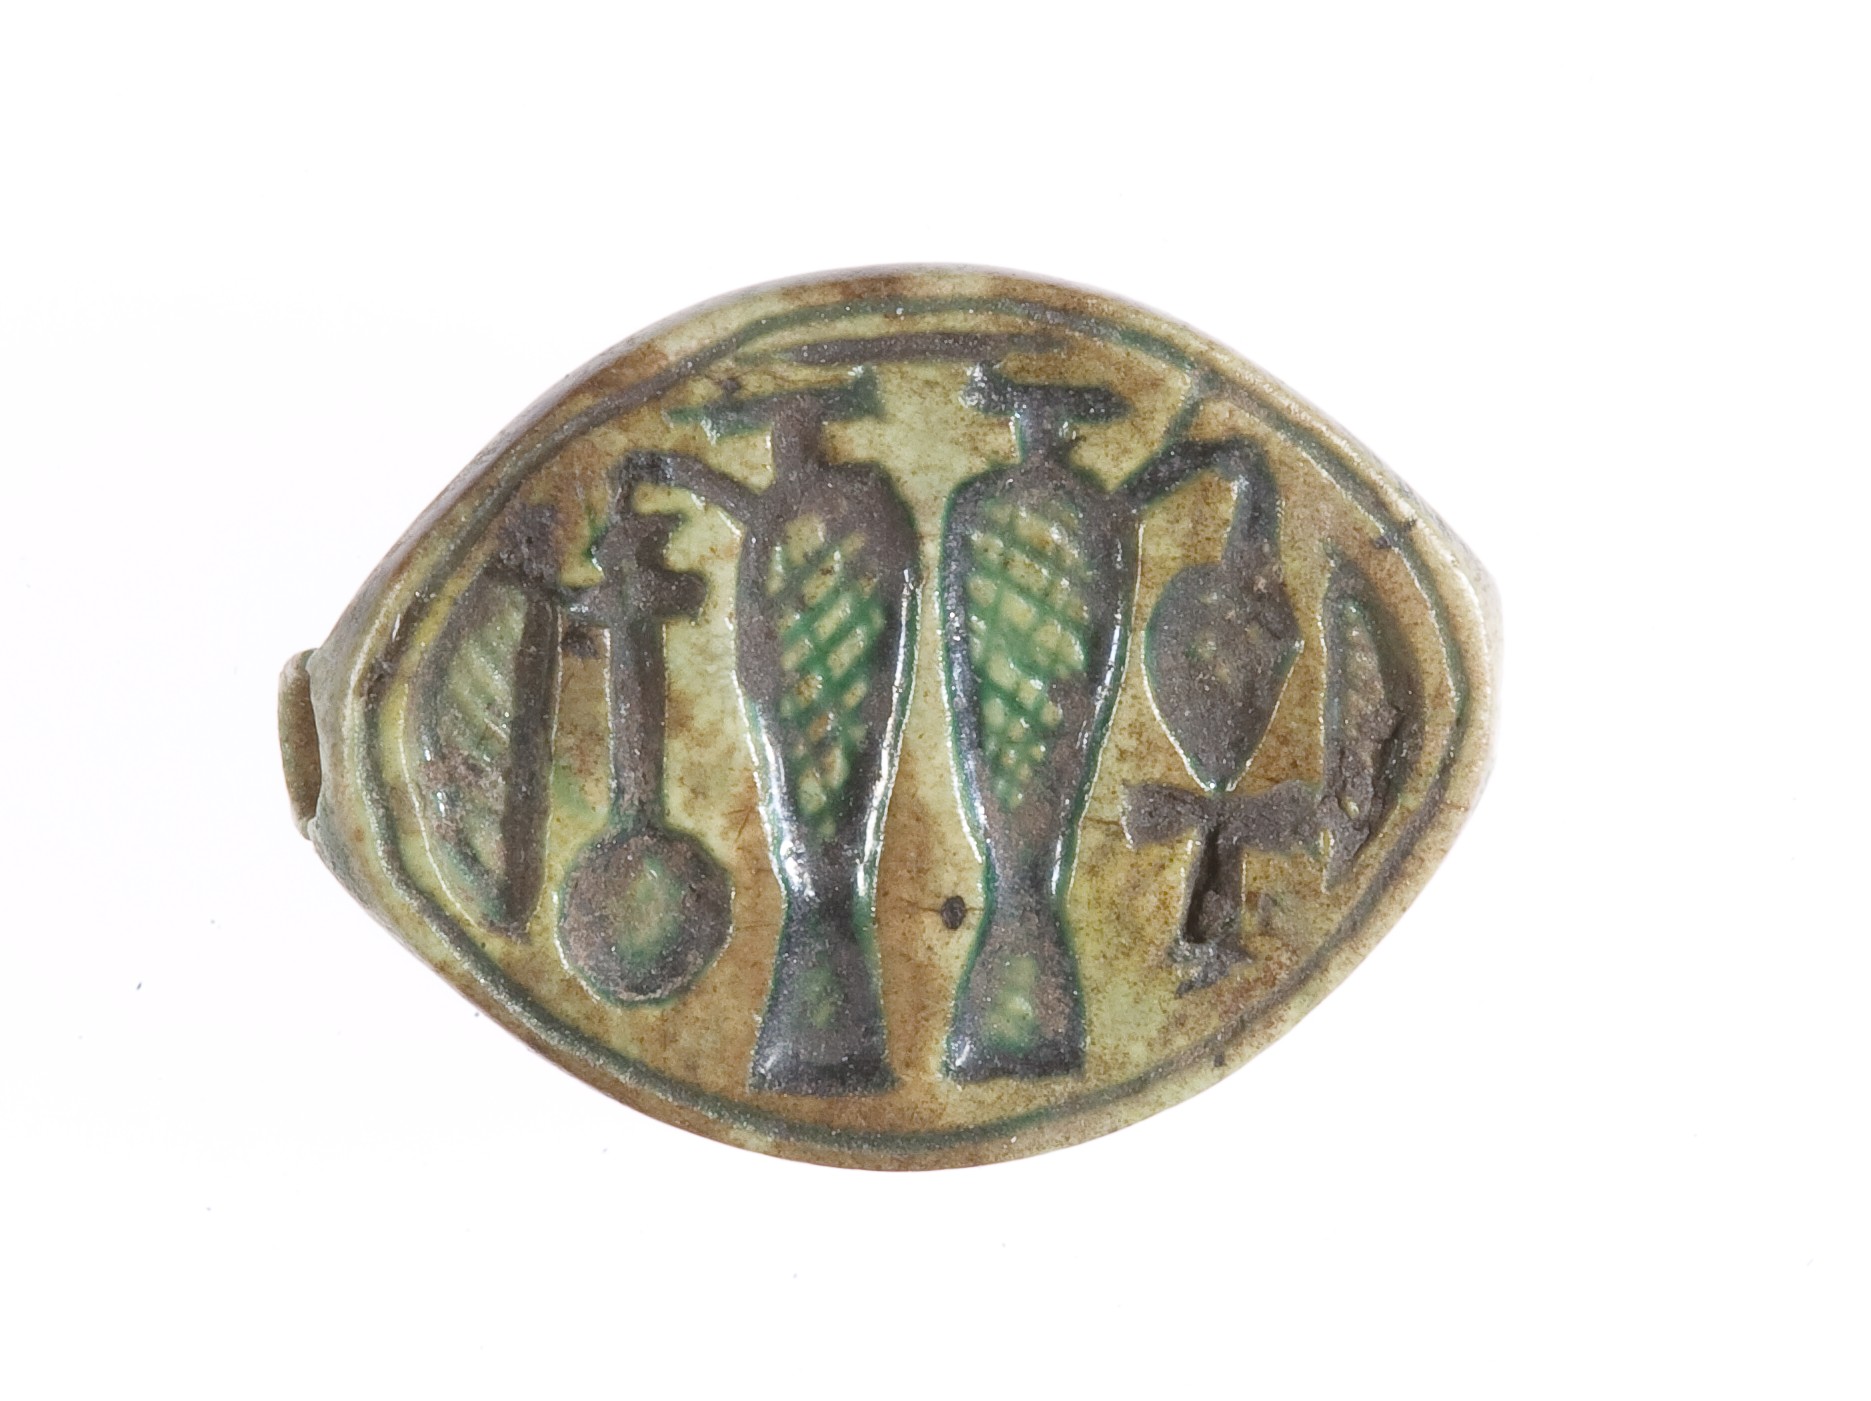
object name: scaraboid, he, nefer, ankh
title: Scaraboid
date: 1635-1458 BCE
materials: stone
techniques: glazing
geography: egypt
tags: scarabs